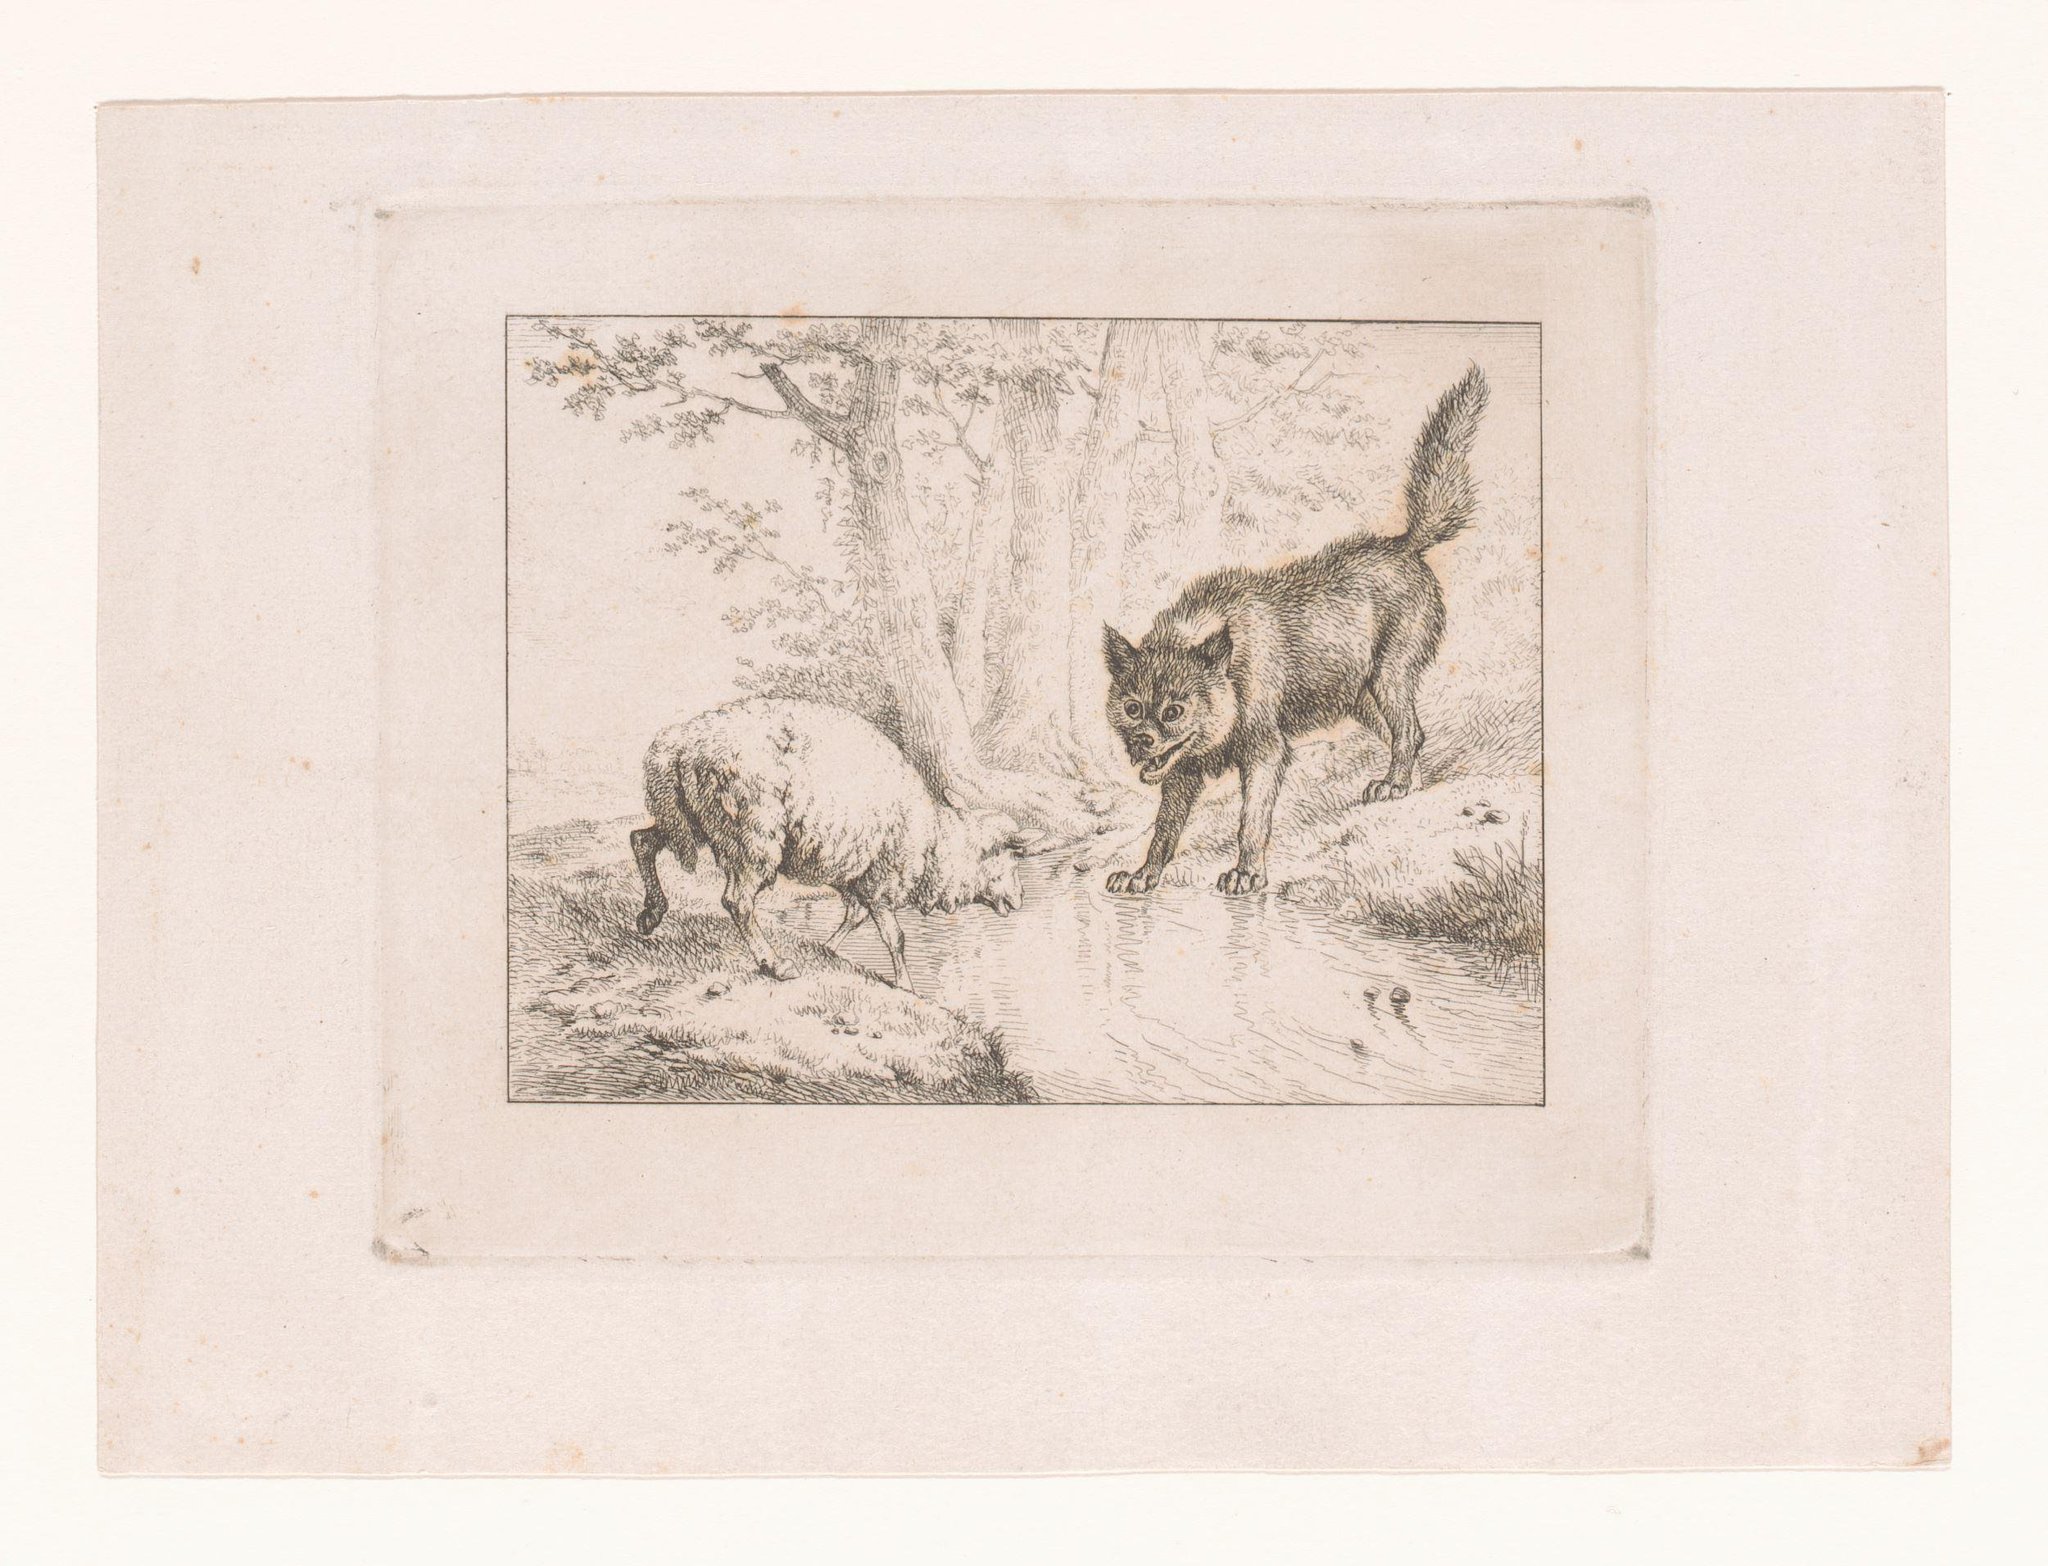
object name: print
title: Fabel van de wolf en het lam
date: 1808-1881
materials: paper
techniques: etching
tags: lamb, fables, beasts of prey, predatory animals: wolf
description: Variatie op de prent met de fabel van de wolf en het lam van Eugène Verboeckhoven, met een andere achtergrond en het lam in een andere houding.